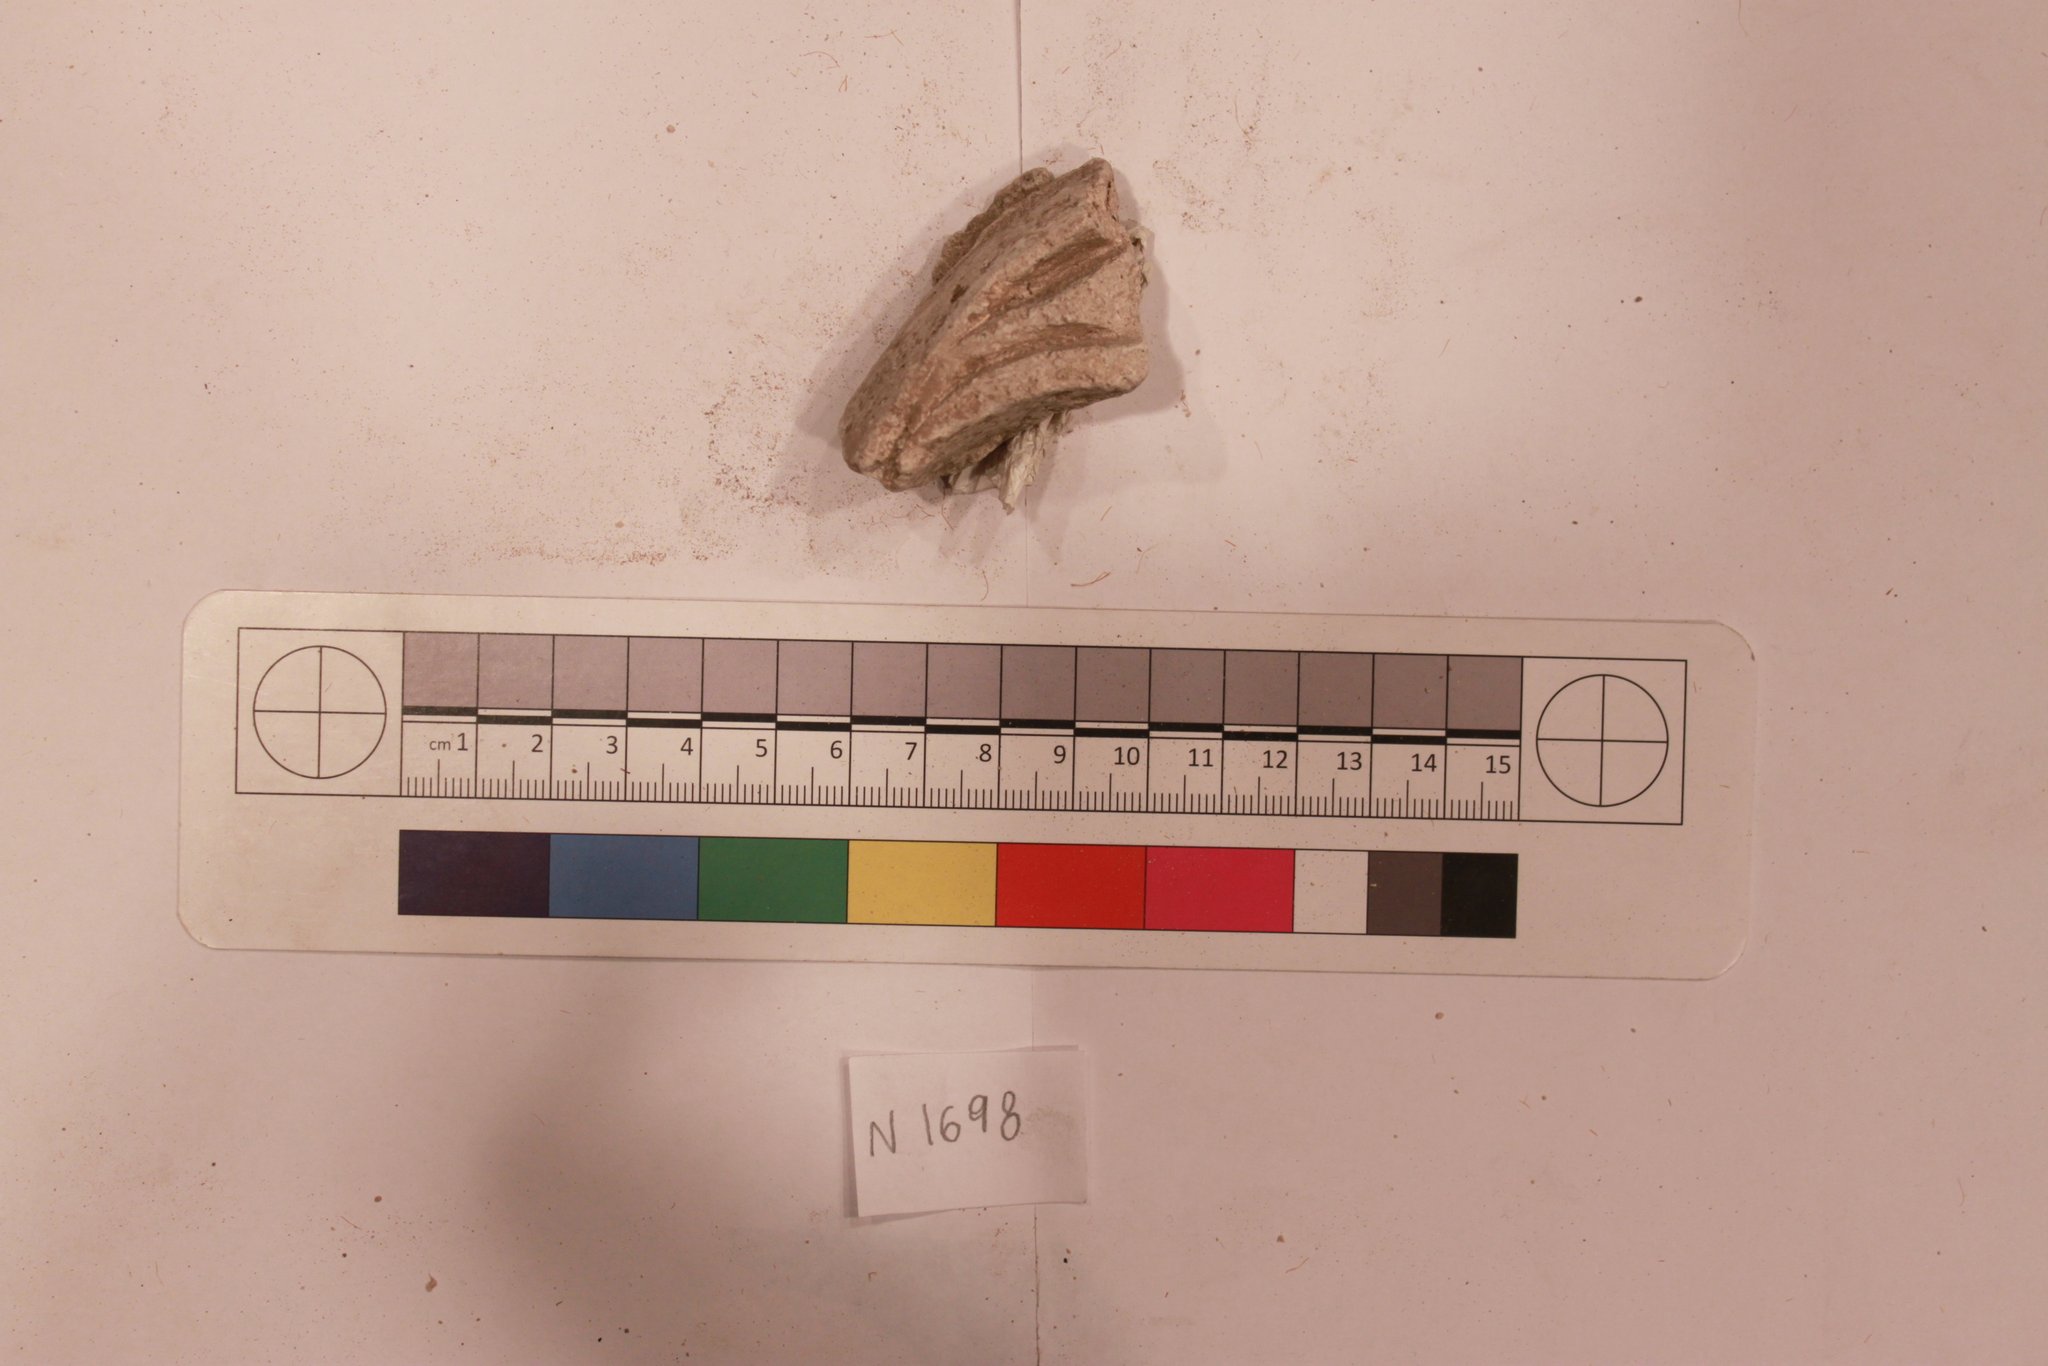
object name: fragment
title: Stucco Fragment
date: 701-1200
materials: plaster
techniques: carving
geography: iran